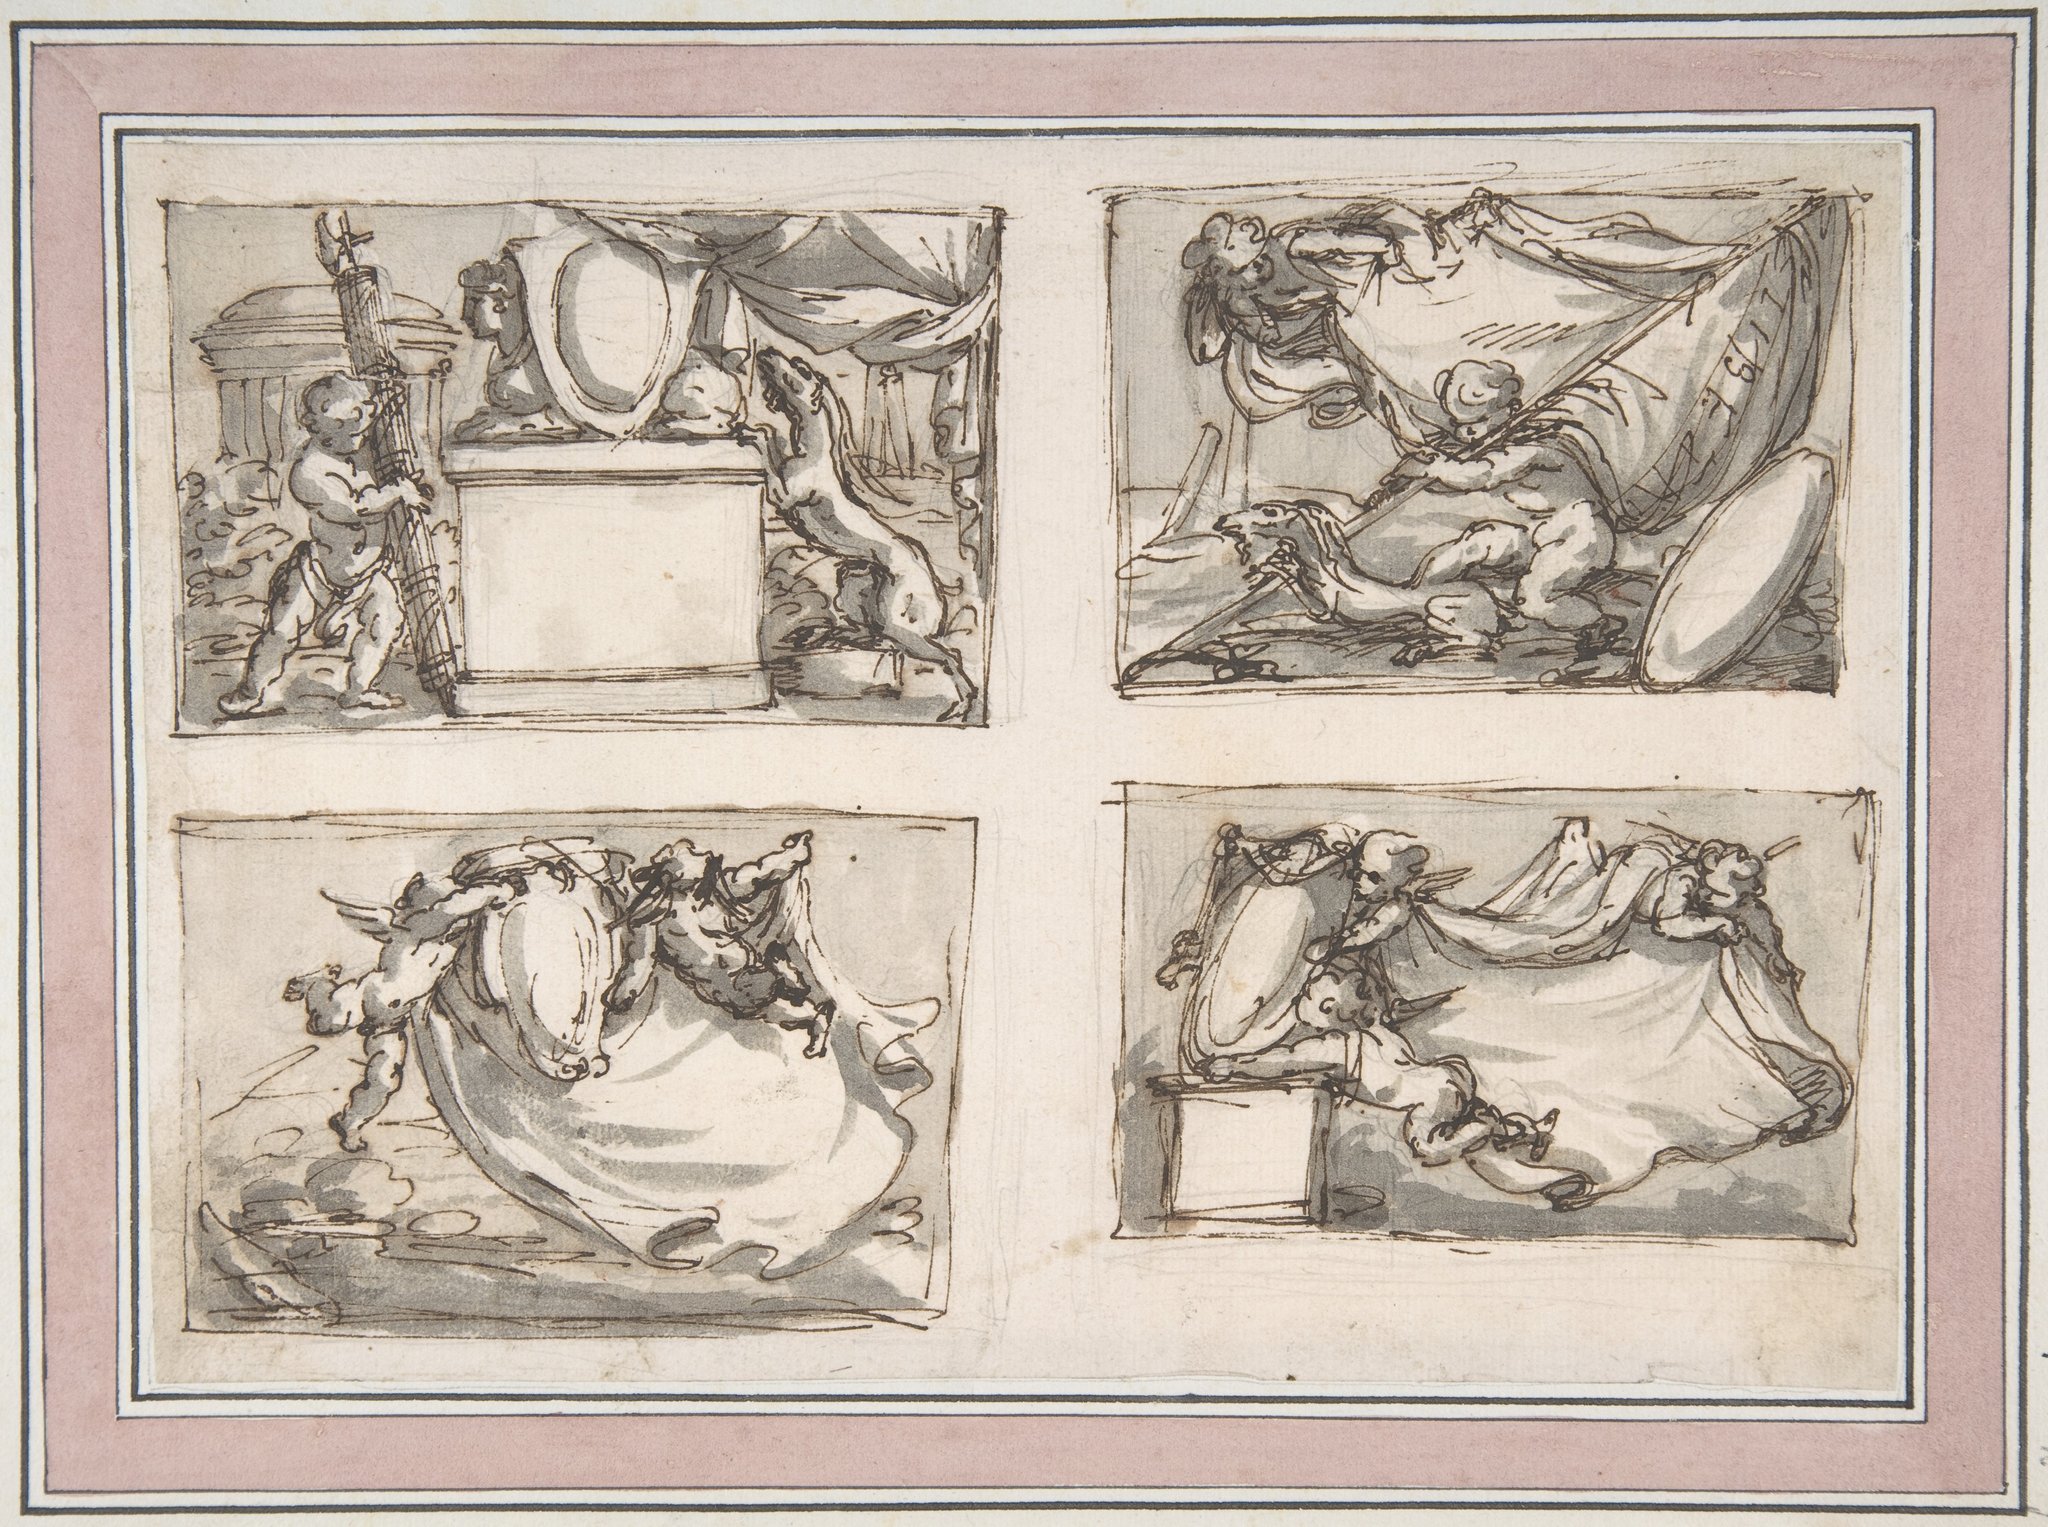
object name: drawing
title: Four Sketches of Putti Hanging Coat of Arms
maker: carlo marchionni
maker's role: artist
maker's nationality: italian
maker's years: 1702-1786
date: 1702-1786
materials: ink, drawing material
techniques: brush, pen, wash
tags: human figures,coat of arms